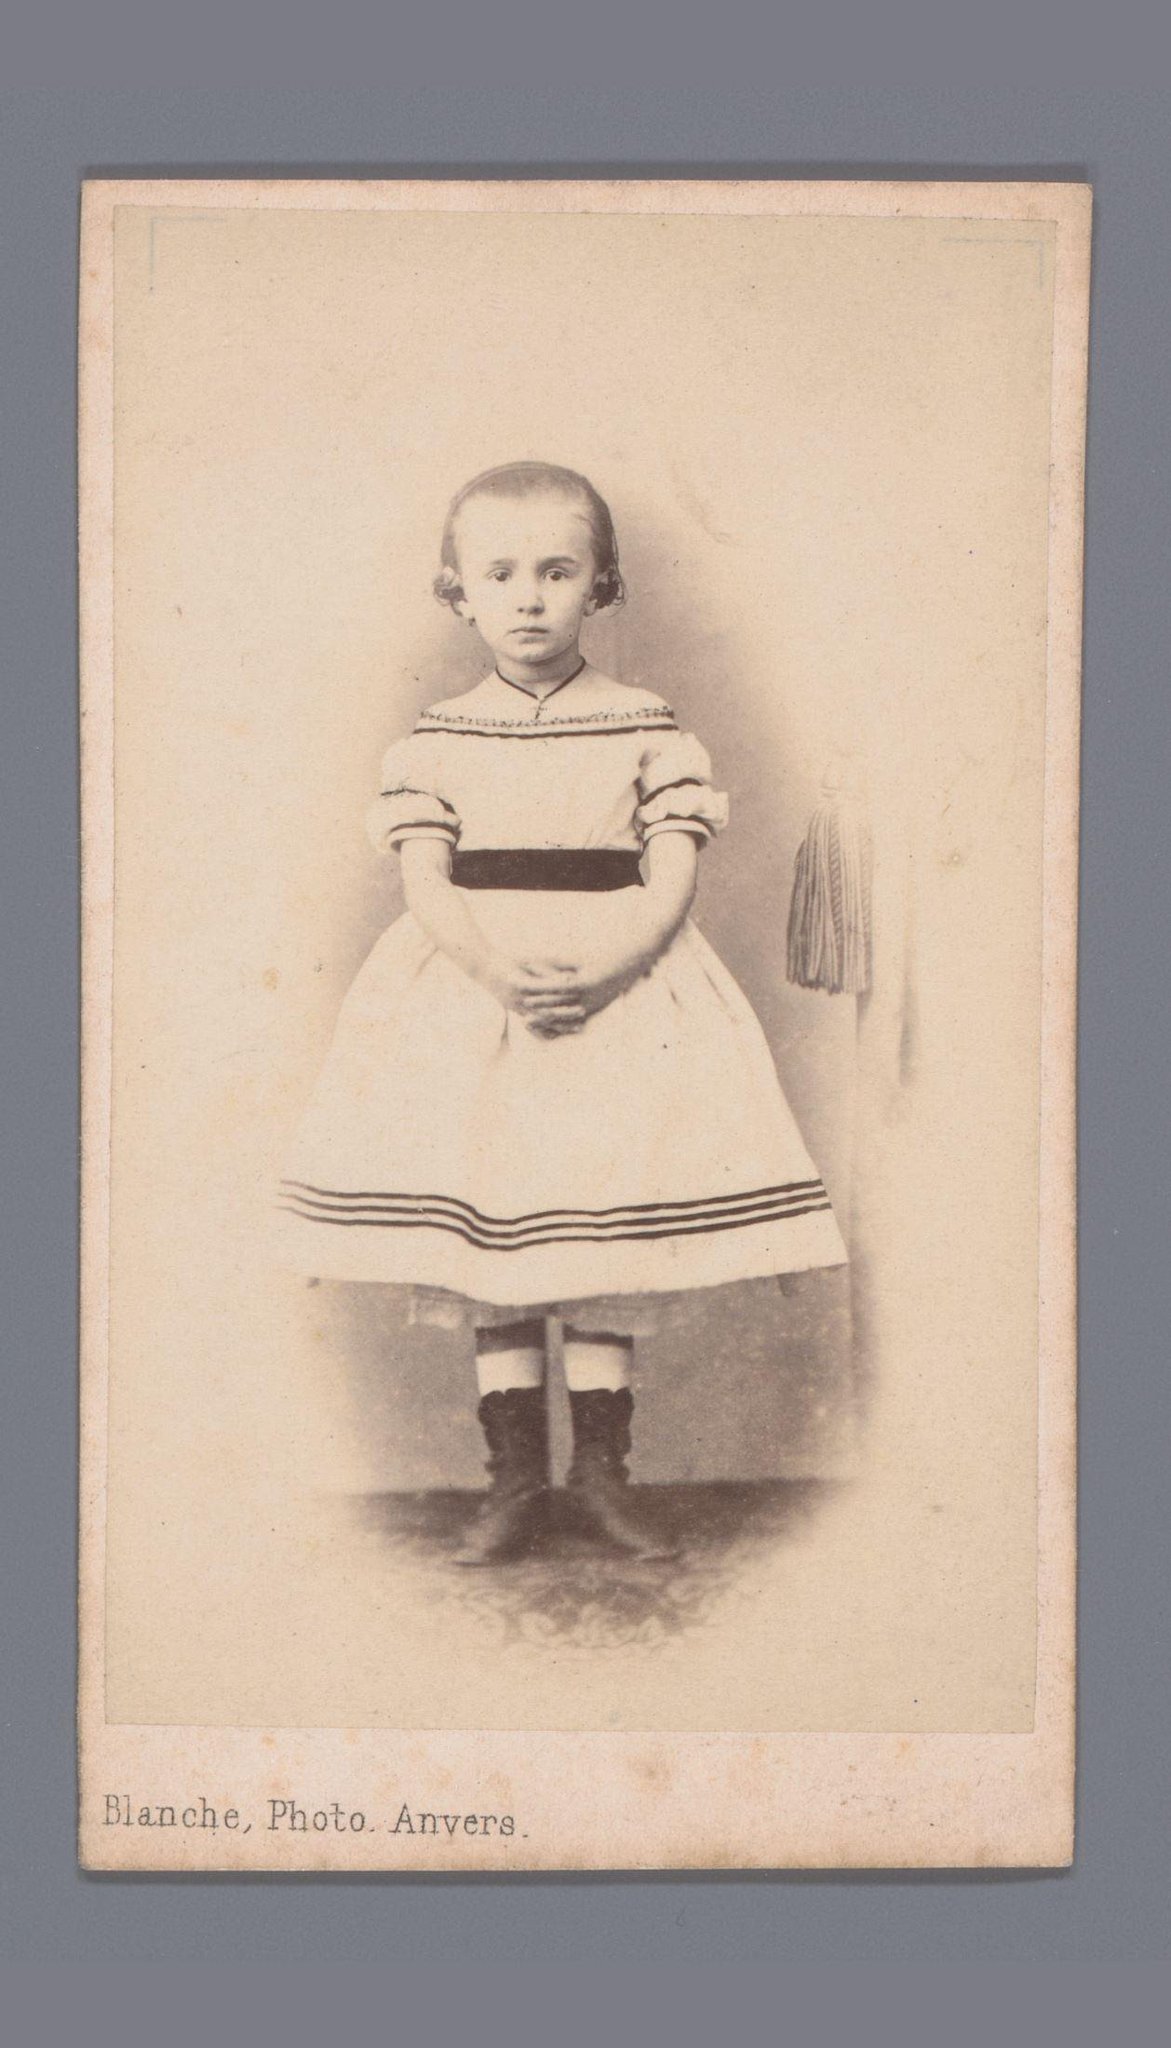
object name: photograph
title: Portret van een onbekend meisje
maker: auguste blanche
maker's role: fotograaf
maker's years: 1818-1866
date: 1863-1866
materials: cardboard, paper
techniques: albumen print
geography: antwerp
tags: girl (child between toddler and youth), anonymous historical person portrayed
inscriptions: address: ‘Rue des Aveugles/ & Place du Musée/ ANVERS’